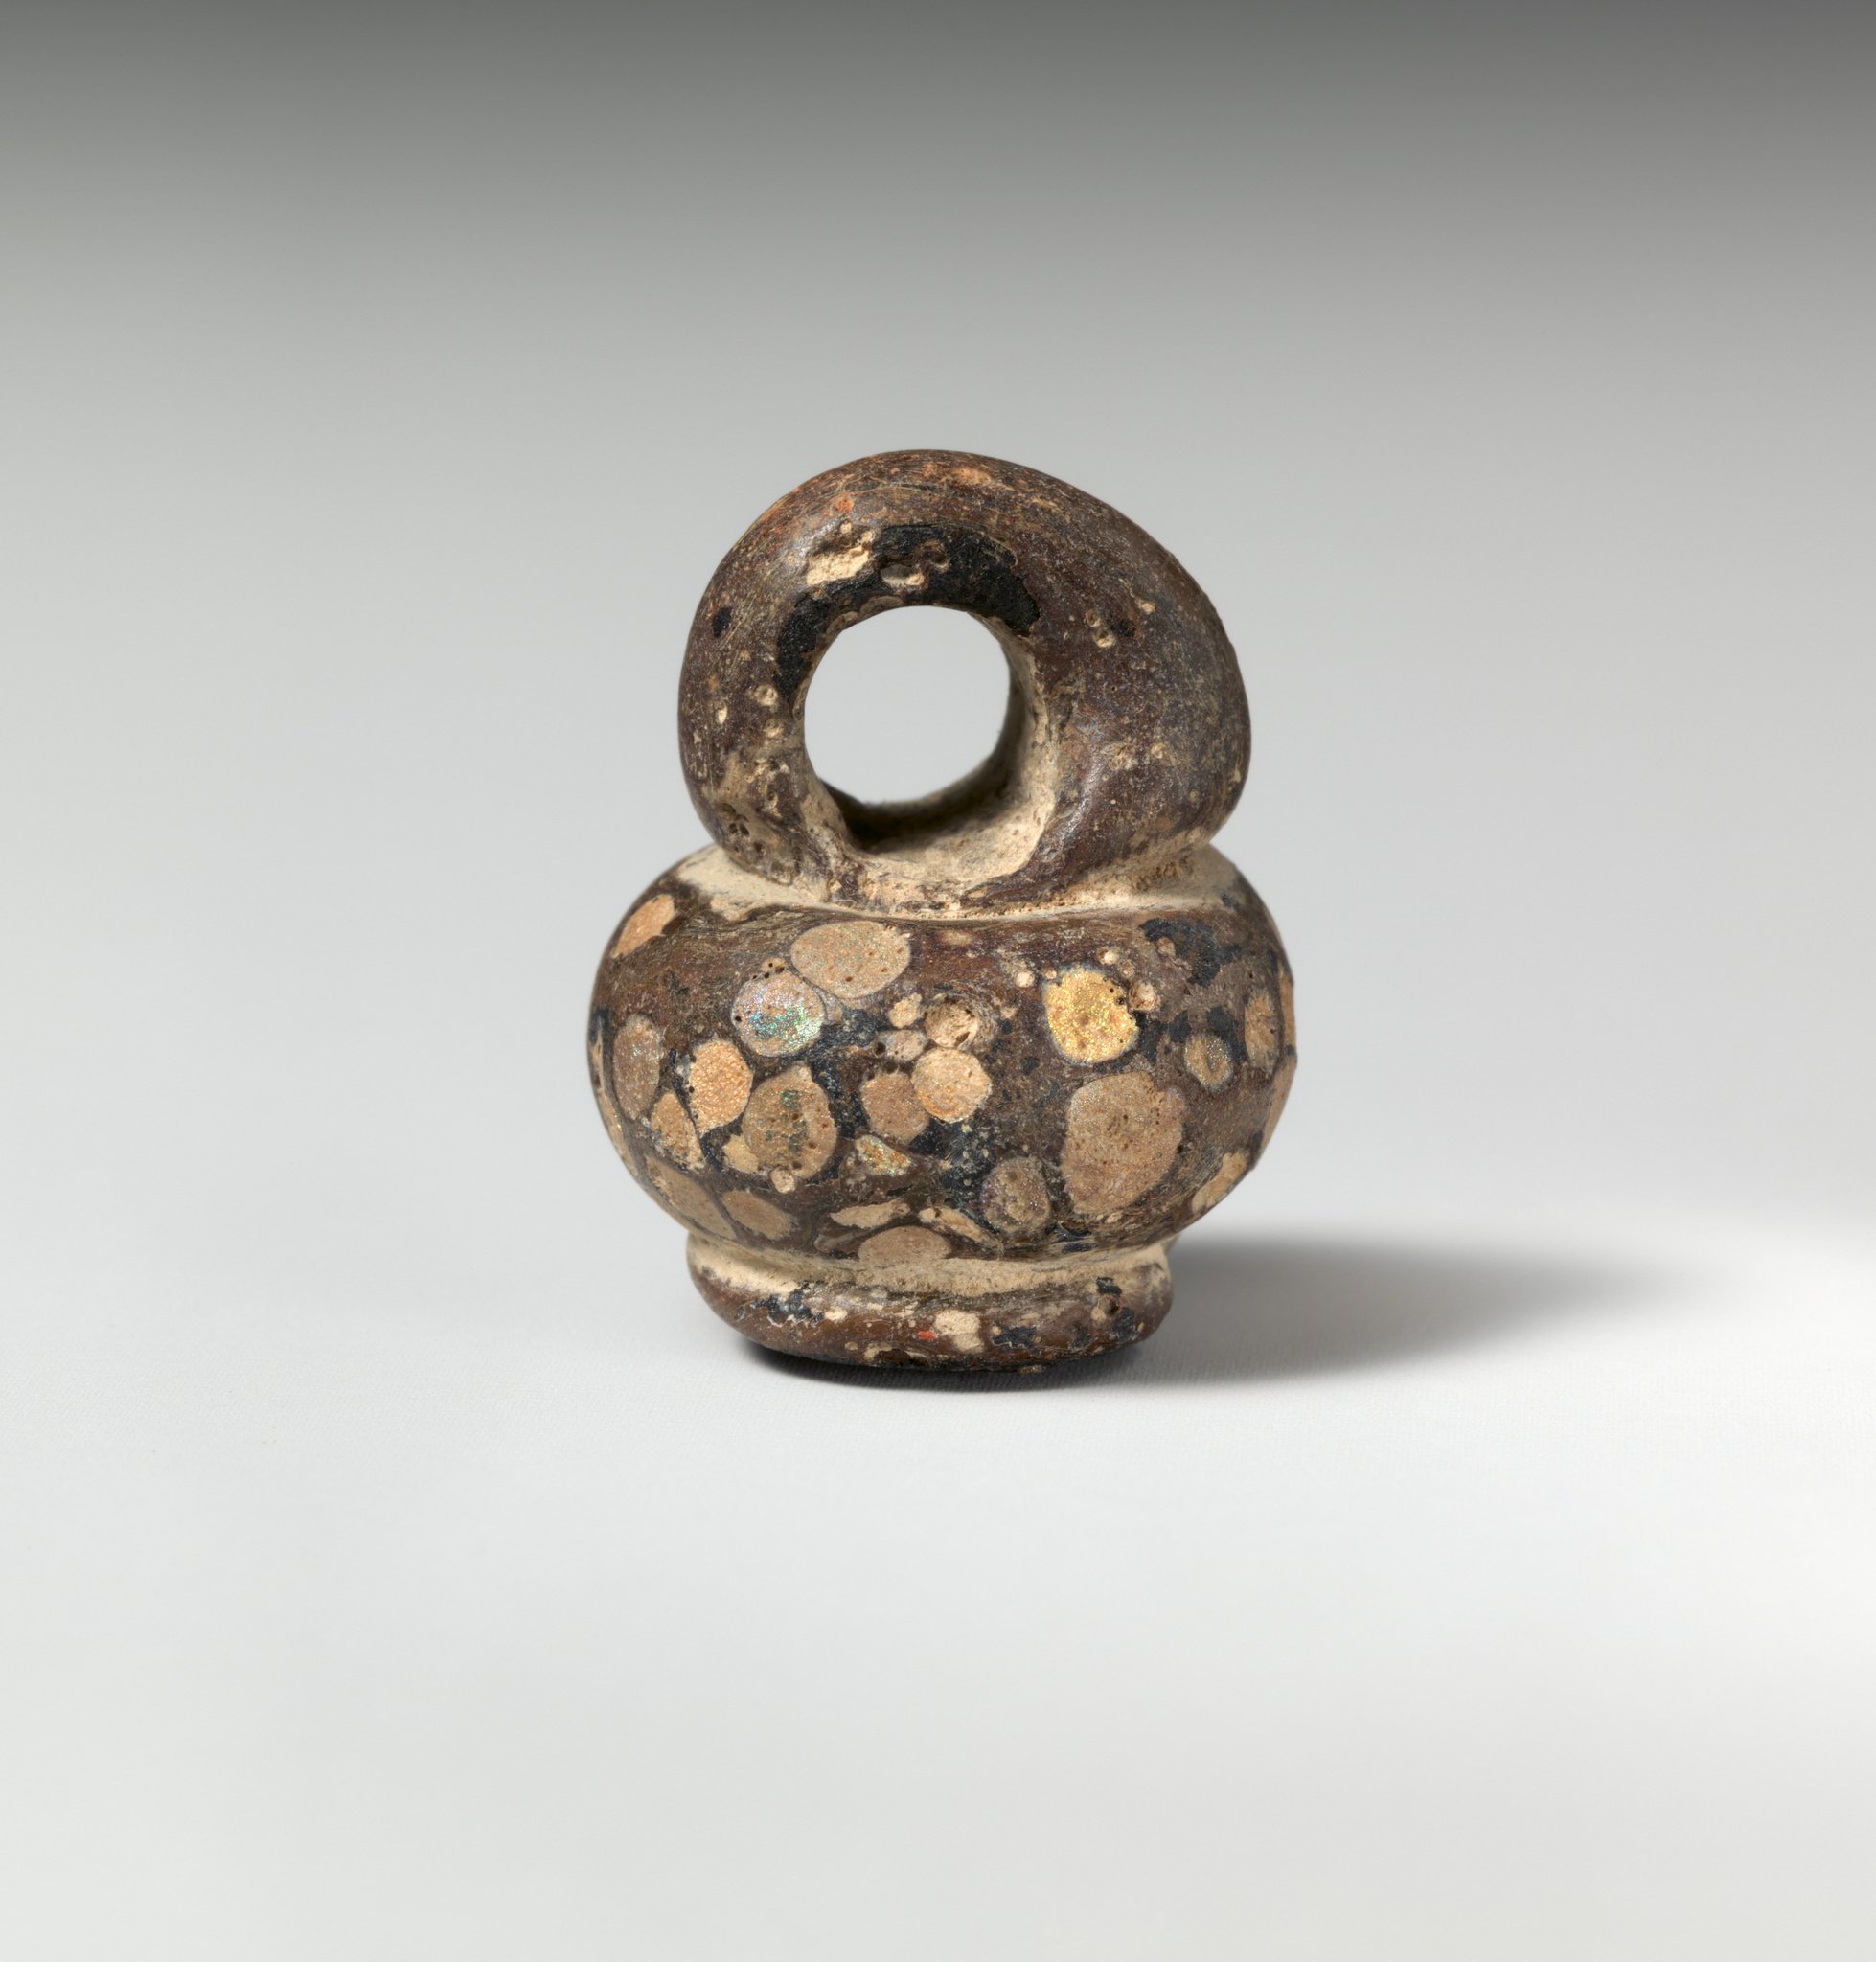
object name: pendant in the form of a jar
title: Glass pendant in the form of a miniature jar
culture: roman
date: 267-400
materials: glass